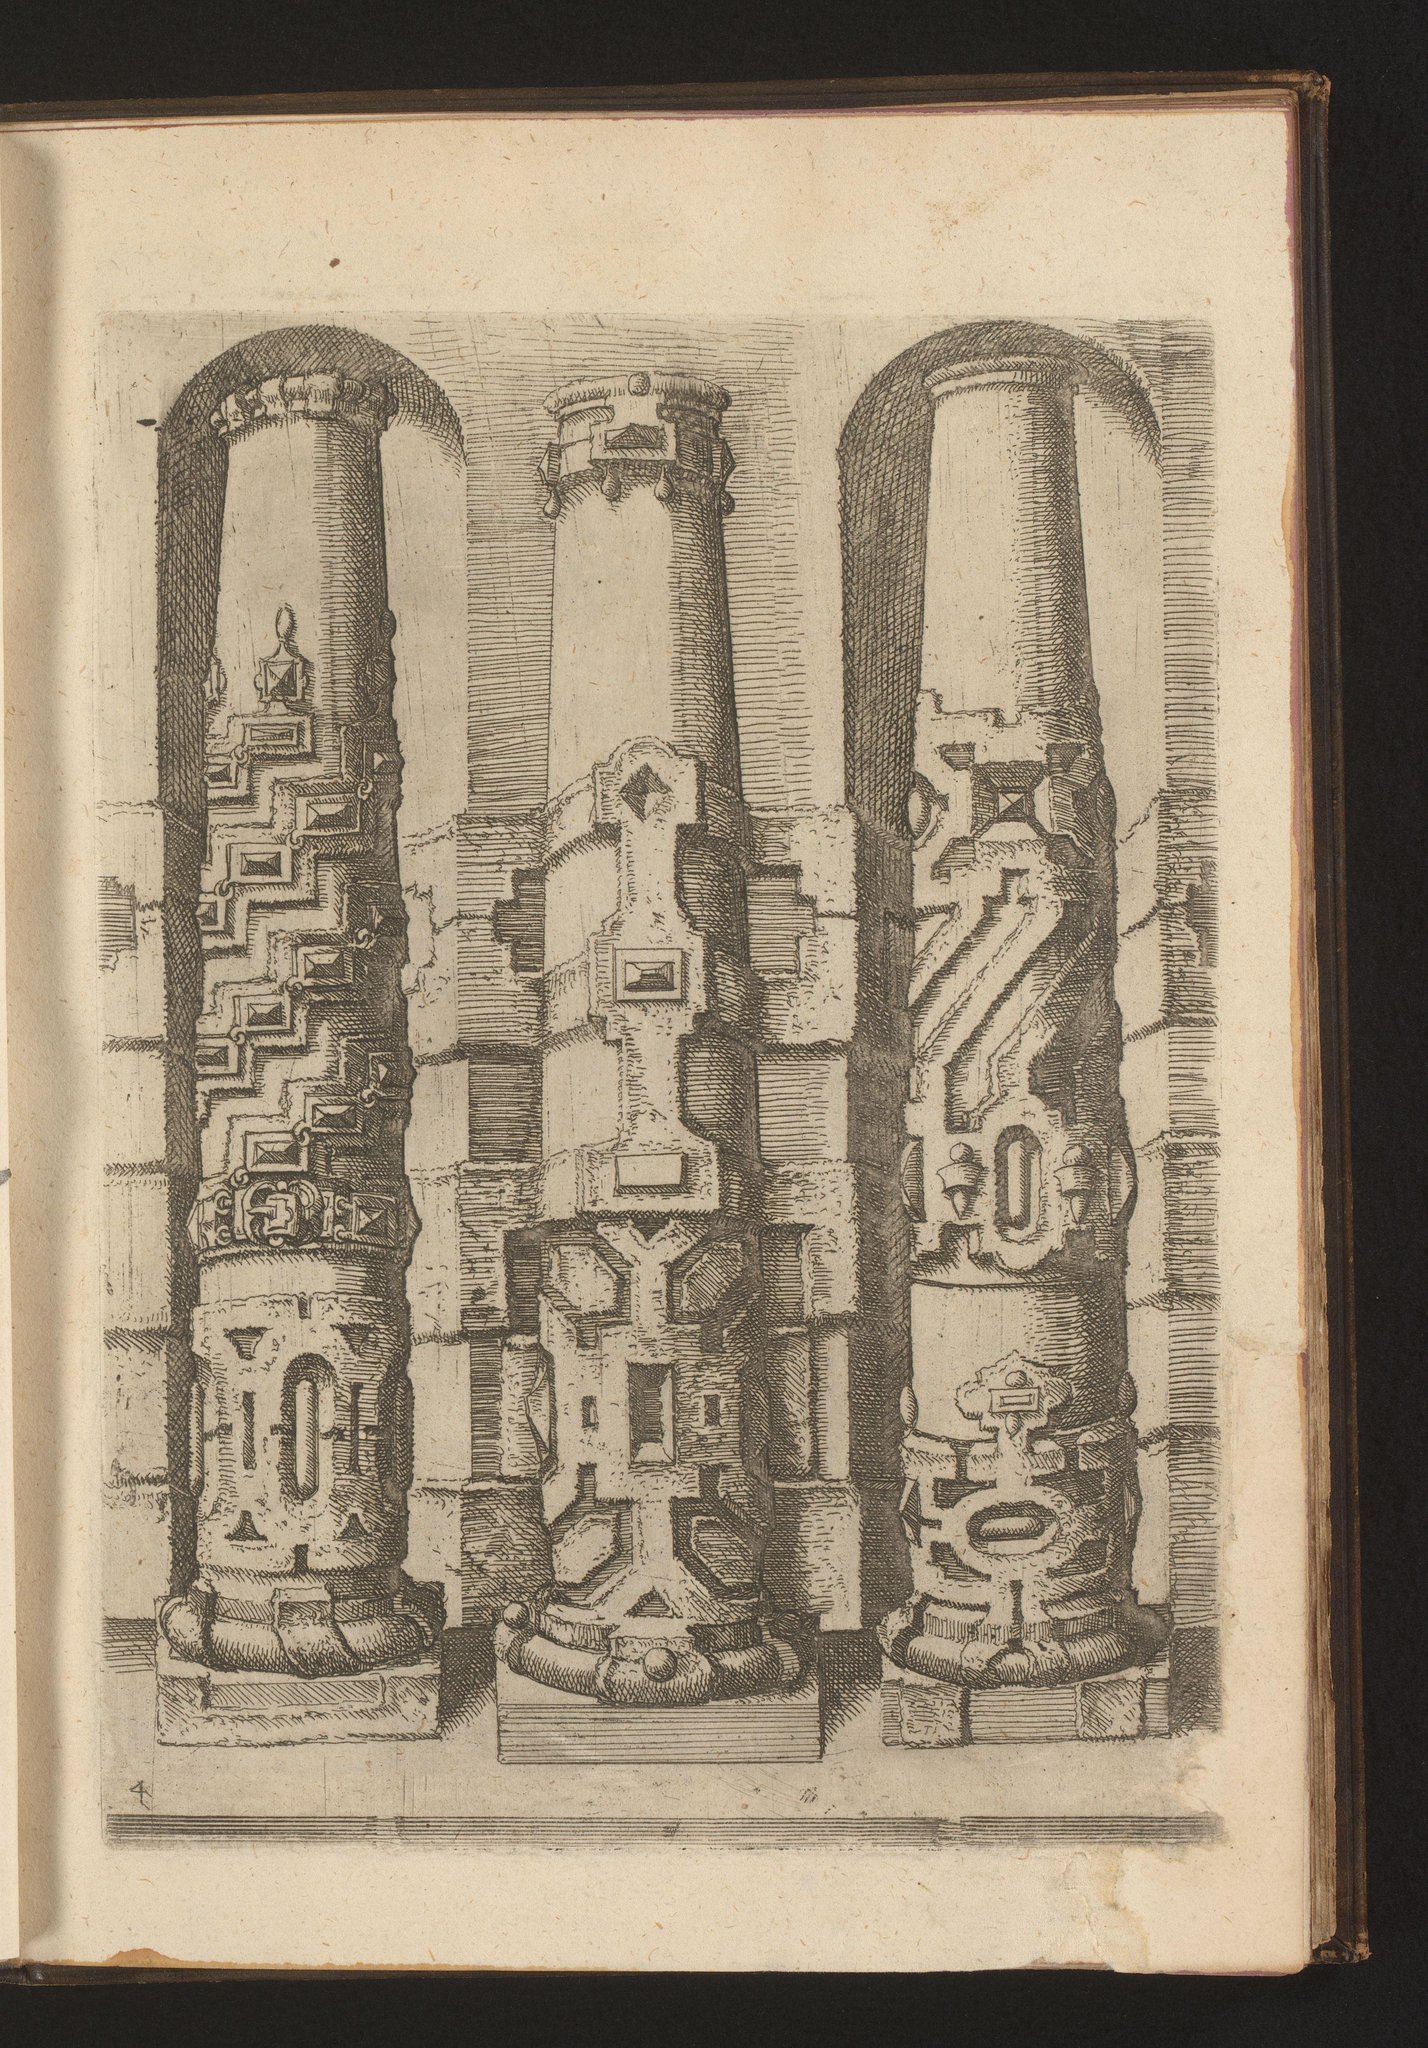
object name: page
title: Architectura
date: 1593-1595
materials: paper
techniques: etching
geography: straatsburg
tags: rustication ~ surface decorations (architecture), column, pillar ~ architecture, tuscan order ~ architecture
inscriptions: collector's mark: Lugt 2228, collector's mark: Lugt 2760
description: Prent gebruikt in: Dietterlin, Wendel (I). Architectura de quinq[ue] columnarum simmetrica distributione et variis eorundem or namentis: Liber I. Straatsburg: Bernhard Jobin, 1593.